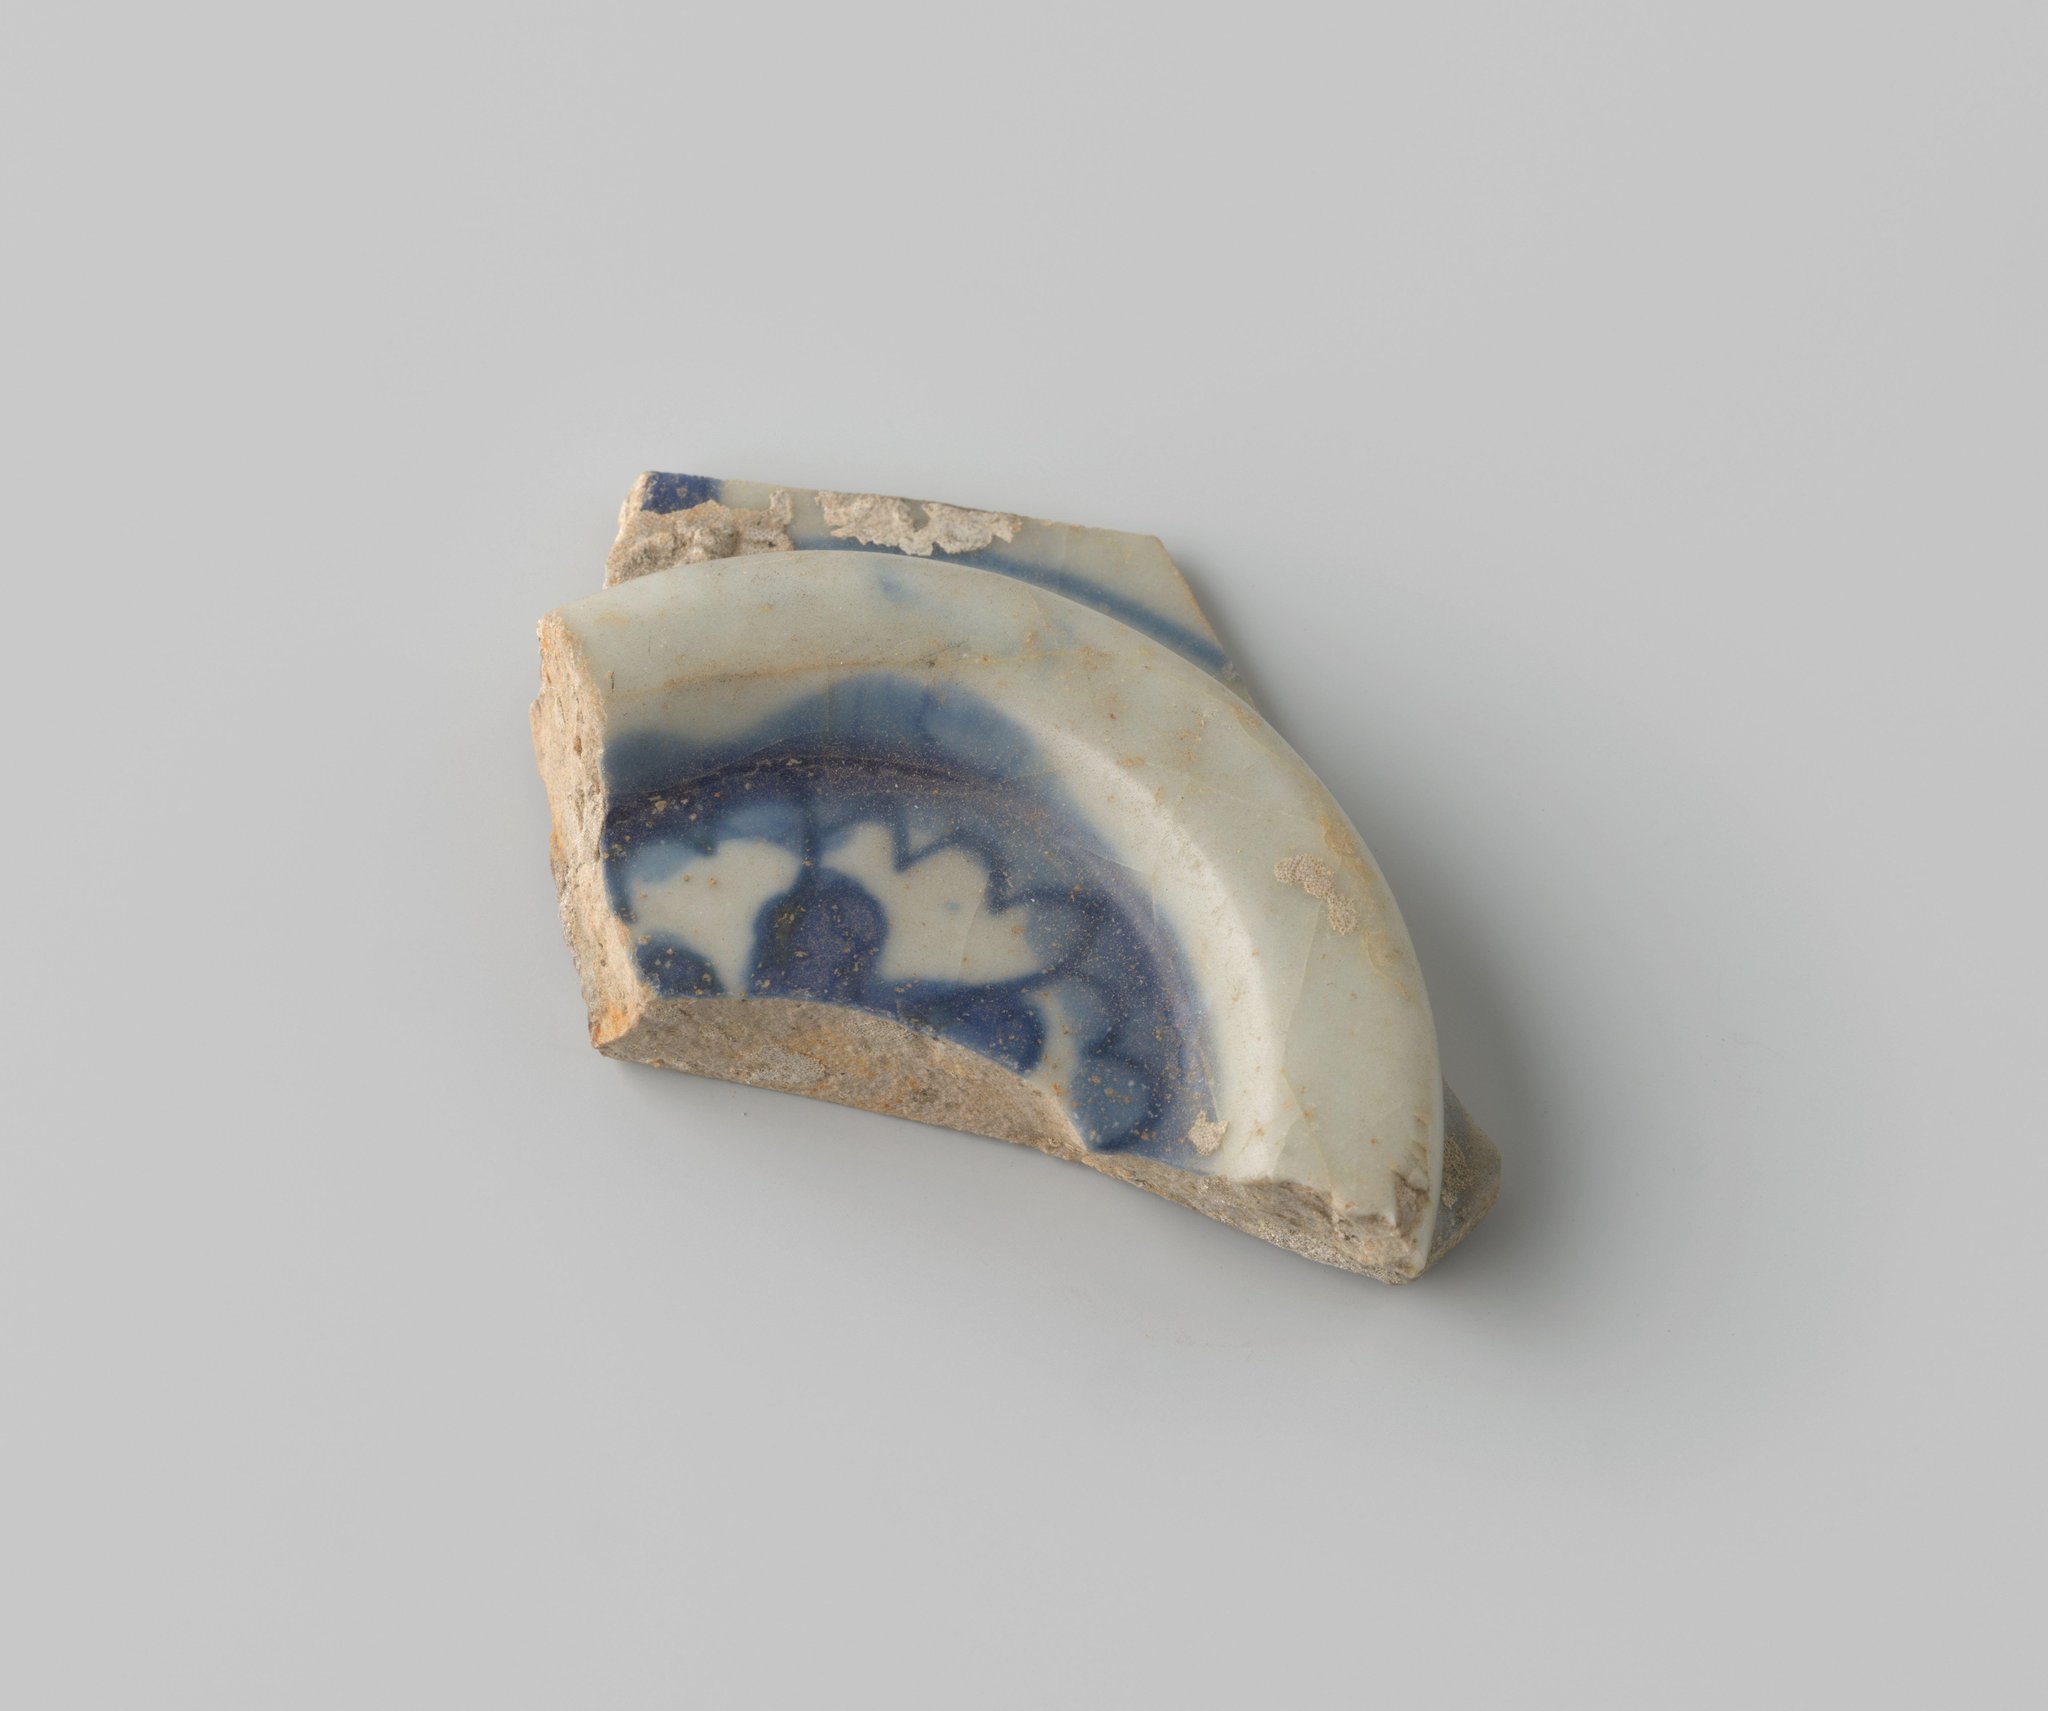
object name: sherd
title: Scherf van een bord uit V.O.C.-schip de 'Witte Leeuw'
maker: Anonymous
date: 1613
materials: porcelain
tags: verenigde oostindische compagnie, sint-helena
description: Scherf van een bord uit V.O.C.-schip de 'Witte Leeuw'.